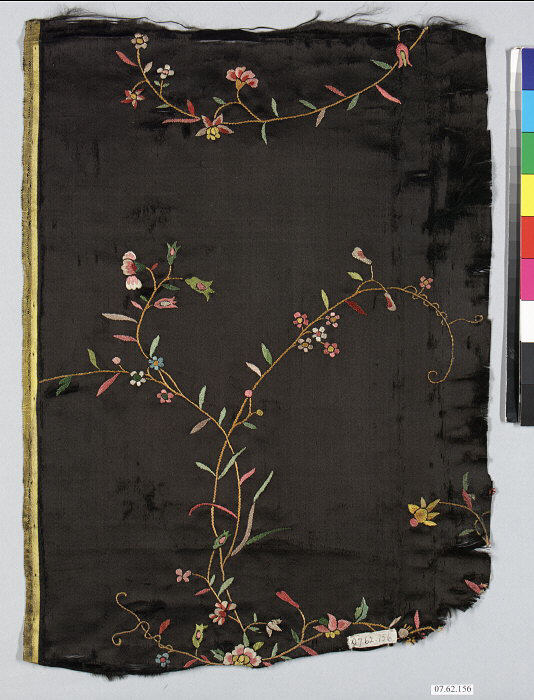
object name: piece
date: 1701-1800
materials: silk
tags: flowers